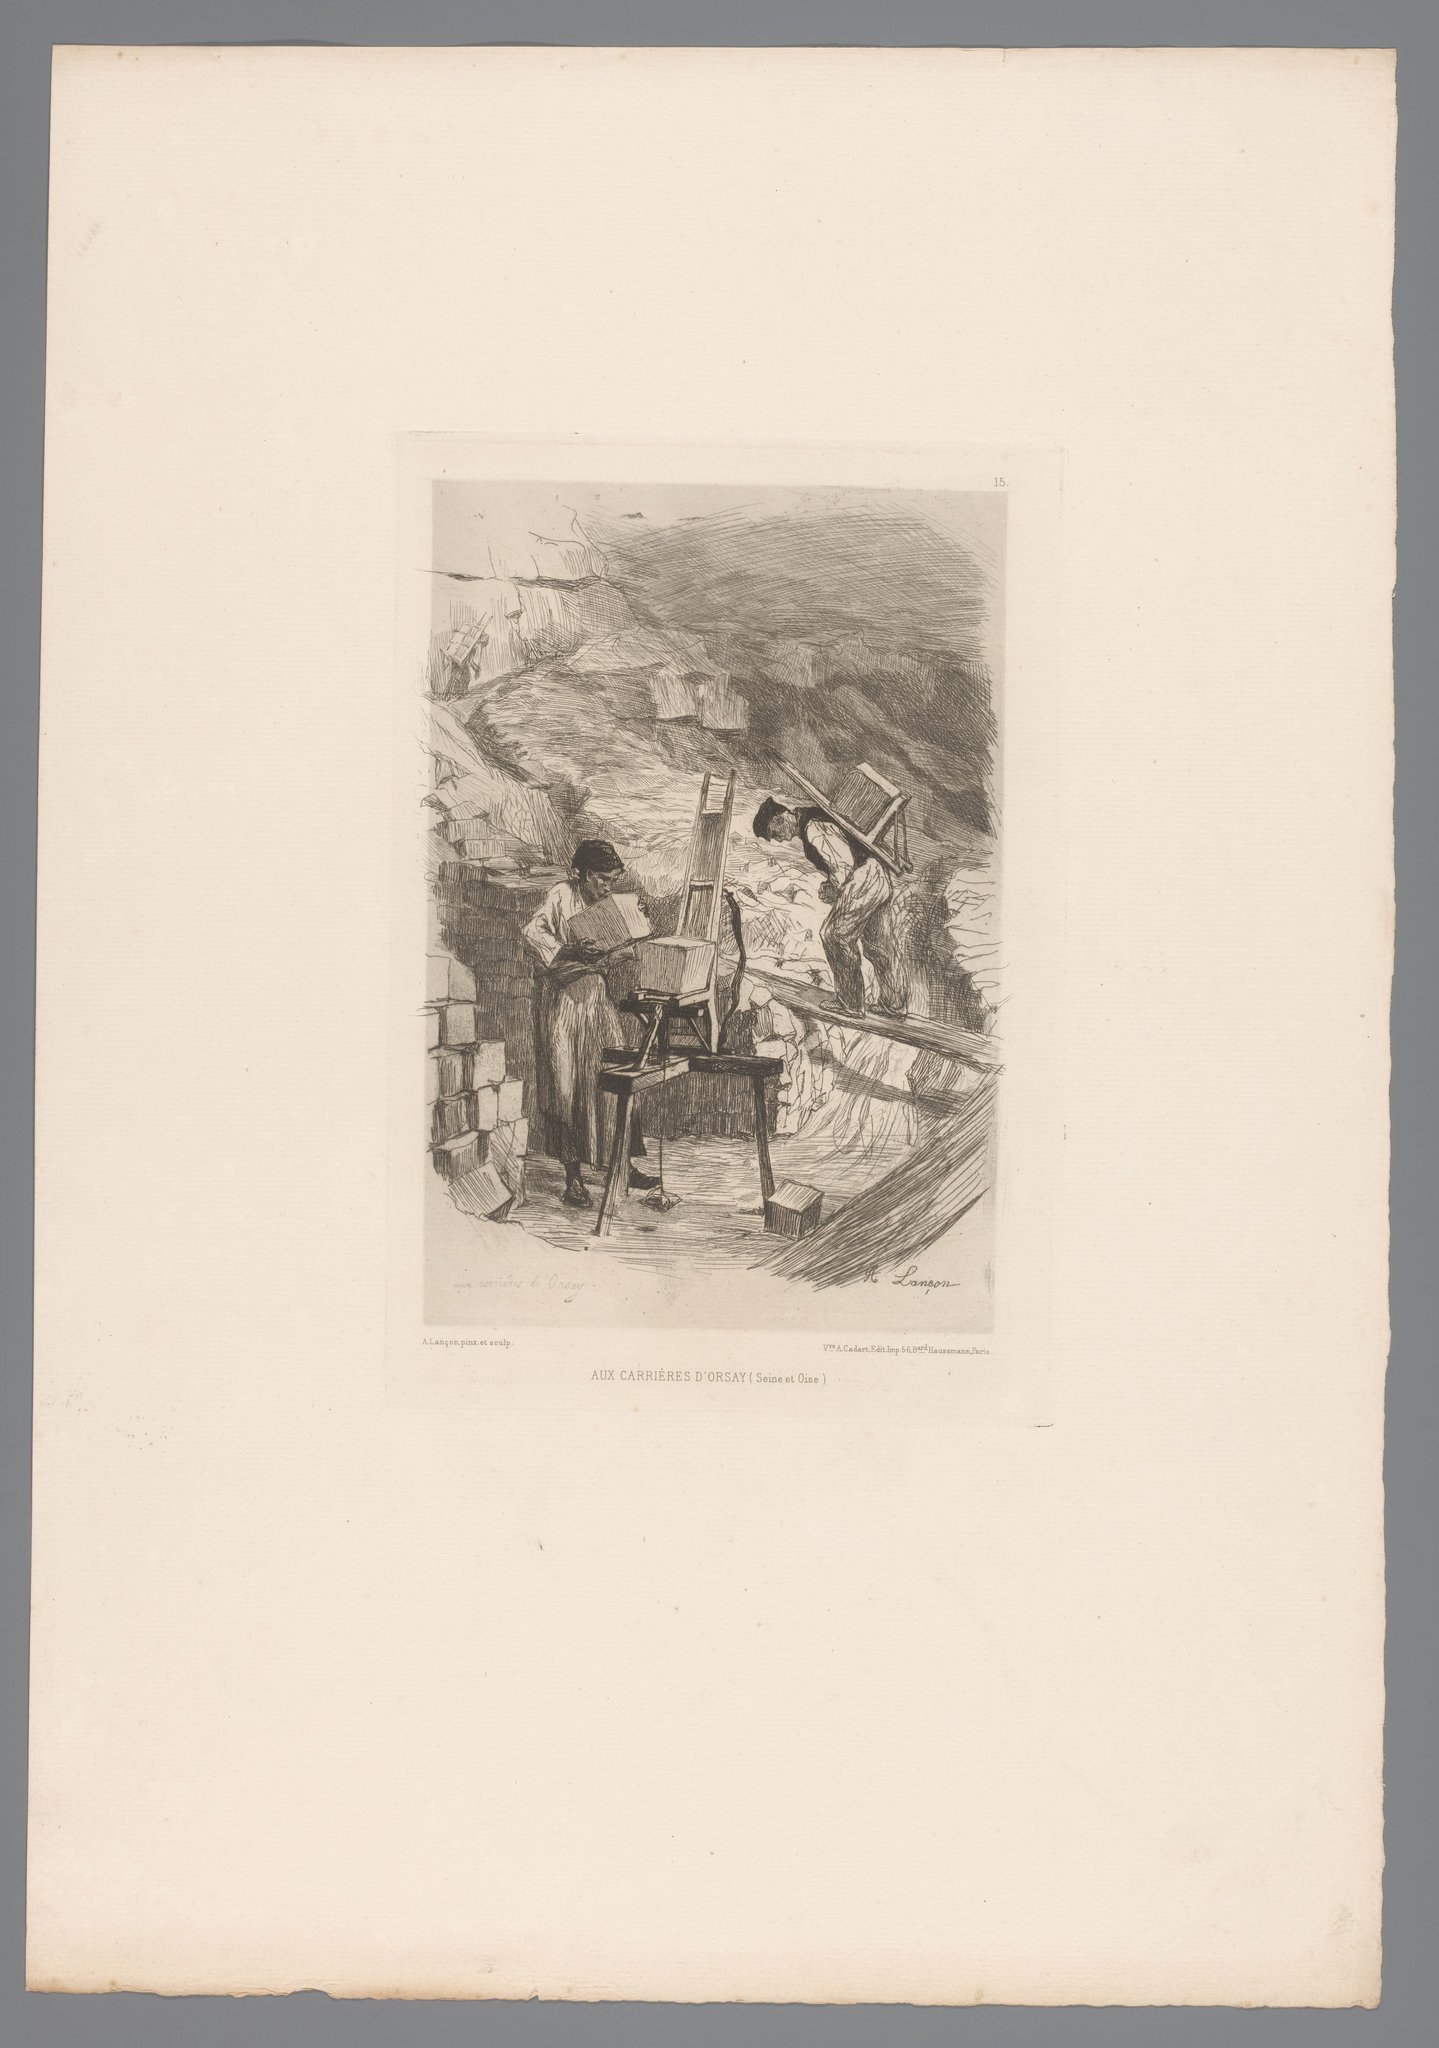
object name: print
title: L'eau-forte en 1876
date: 1876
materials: paper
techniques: drypoint, etching, intaglio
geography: paris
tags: quarry (+ stone)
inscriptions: watermark, collector's mark: Lugt 2228, collector's mark: ‘AFE v S’, collector's mark: Lugt 2760